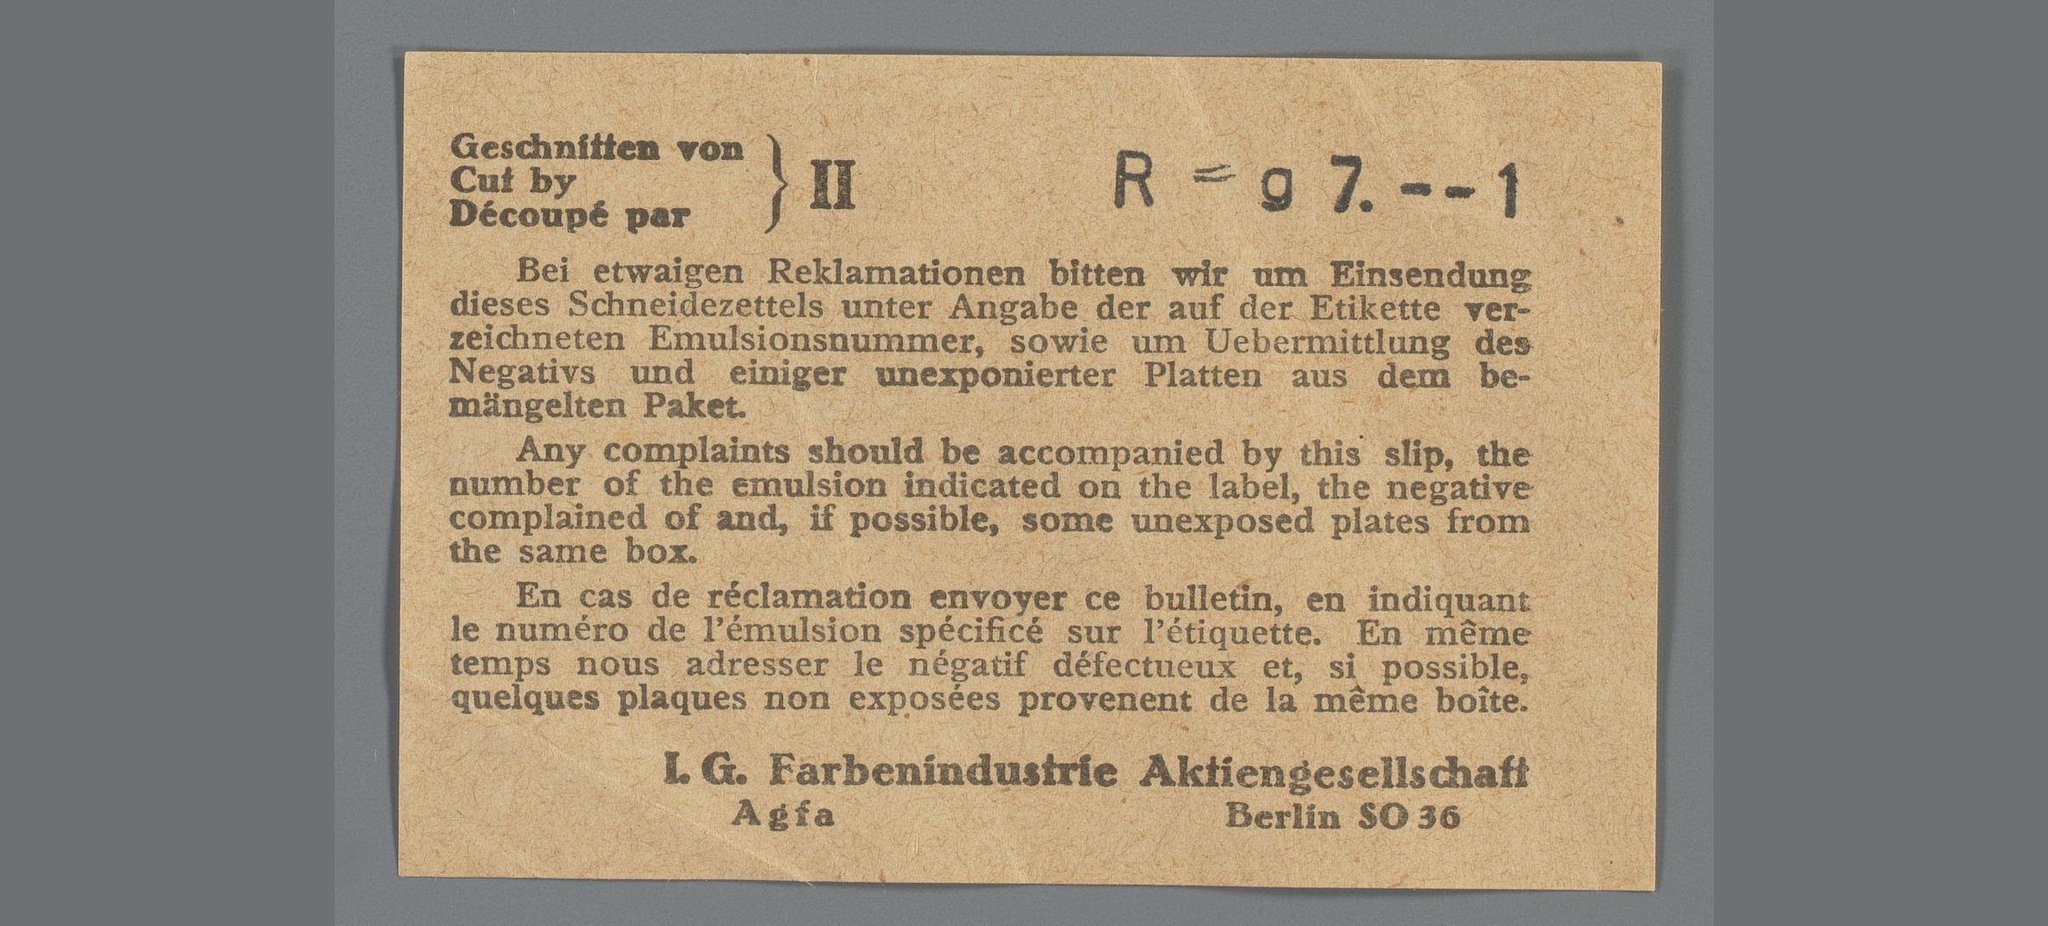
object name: label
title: Etiket met Agfa emulsienummer R g 7--1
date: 1916-1955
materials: paper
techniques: letterpress printing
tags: printed matter